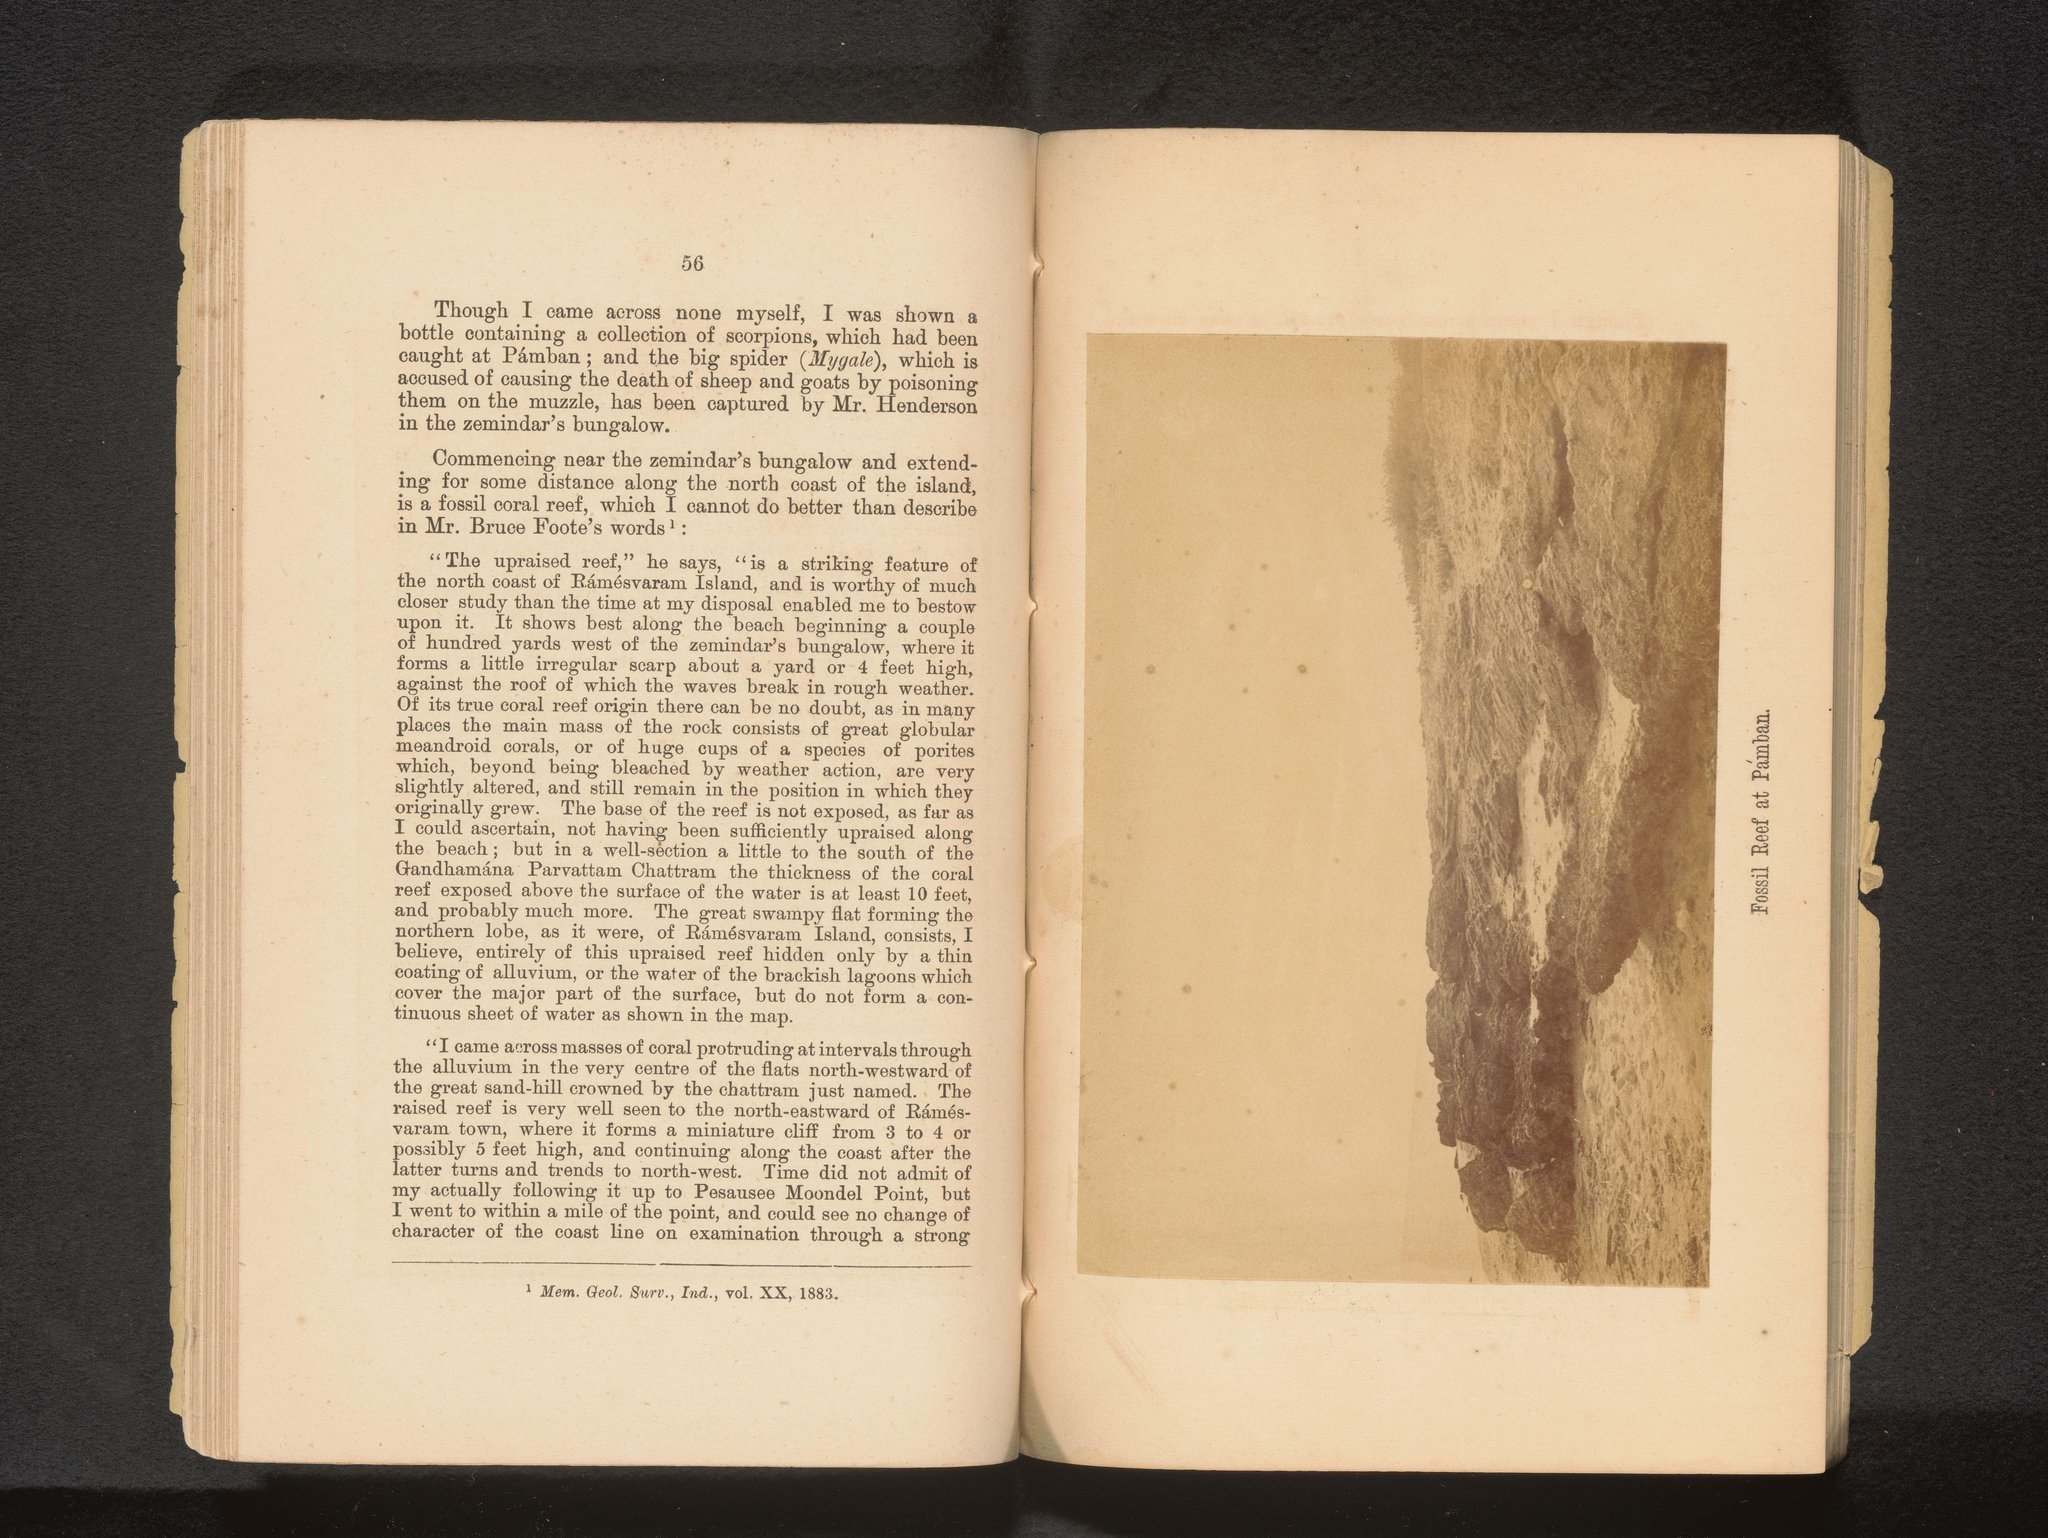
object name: page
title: Fossil reef at Pámban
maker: Anonymous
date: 1880-1890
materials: photographic support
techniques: albumen print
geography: pamban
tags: reef ~ coast, fossil plants